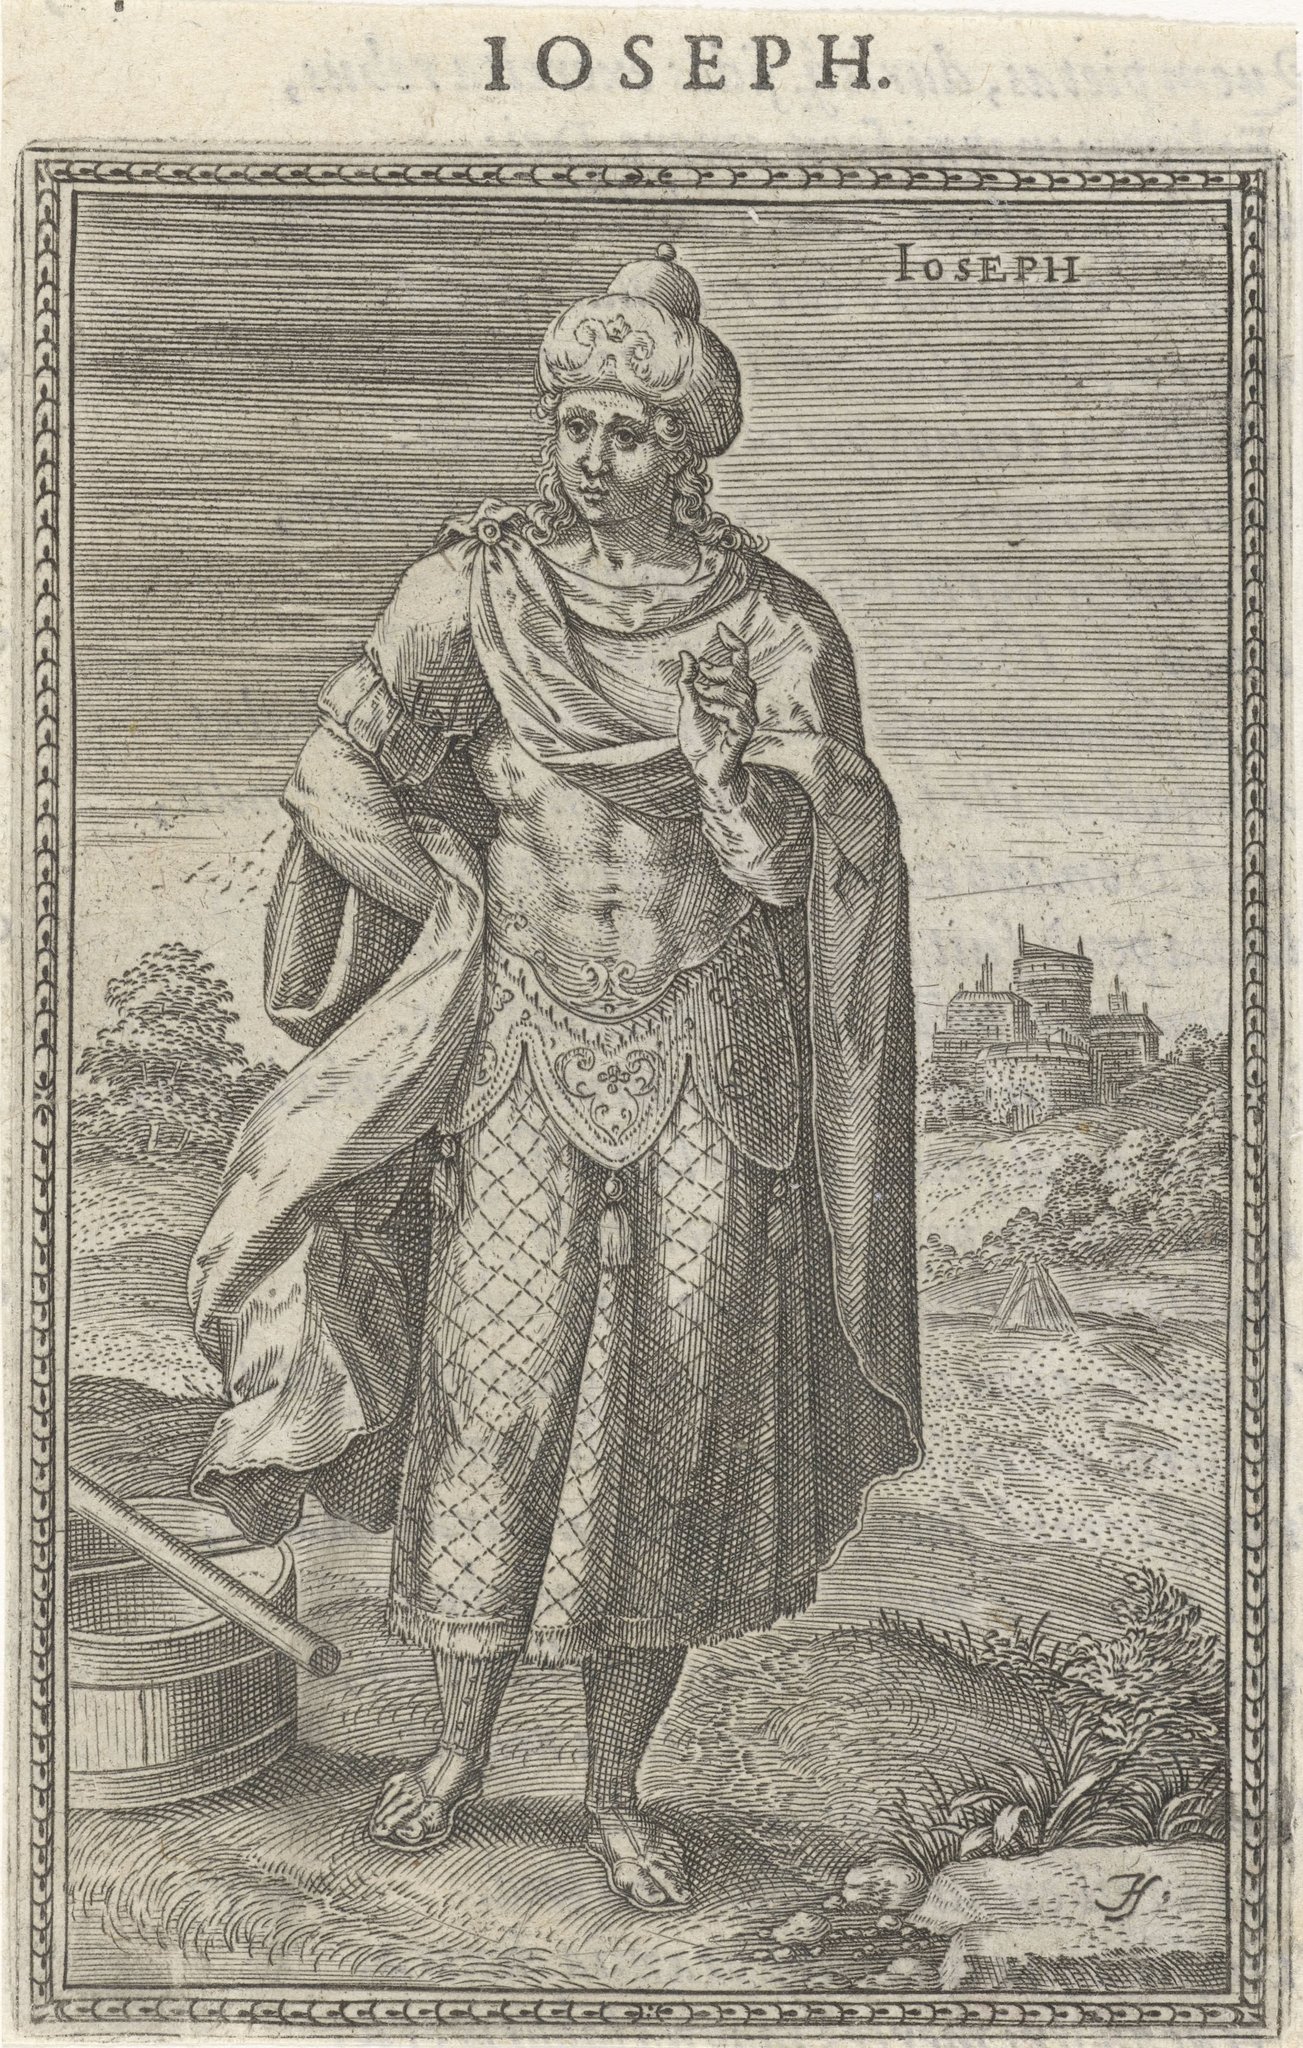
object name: print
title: Ioseph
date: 1577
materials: paper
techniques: engraving, letterpress printing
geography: antwerp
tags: joseph (not in biblical context)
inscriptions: collector's mark: Lugt 240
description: Boekillustratie voor Hillesem, Louis. Sacrarum antiquitatum monumenta. Antwerpen: Christoffel Plantin, 1577.